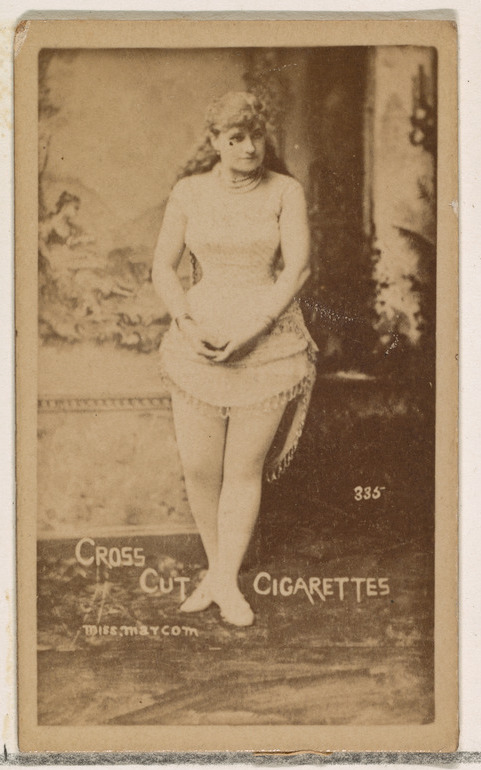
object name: print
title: Card Number 335, Miss Marcom, from the Actors and Actresses series (N145-1) issued by Duke Sons & Co. to promote Cross Cut Cigarettes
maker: w. duke, sons & co.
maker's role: publisher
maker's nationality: american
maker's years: 1870-1920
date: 1880-1889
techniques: albumen silver print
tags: portraits,women,actresses